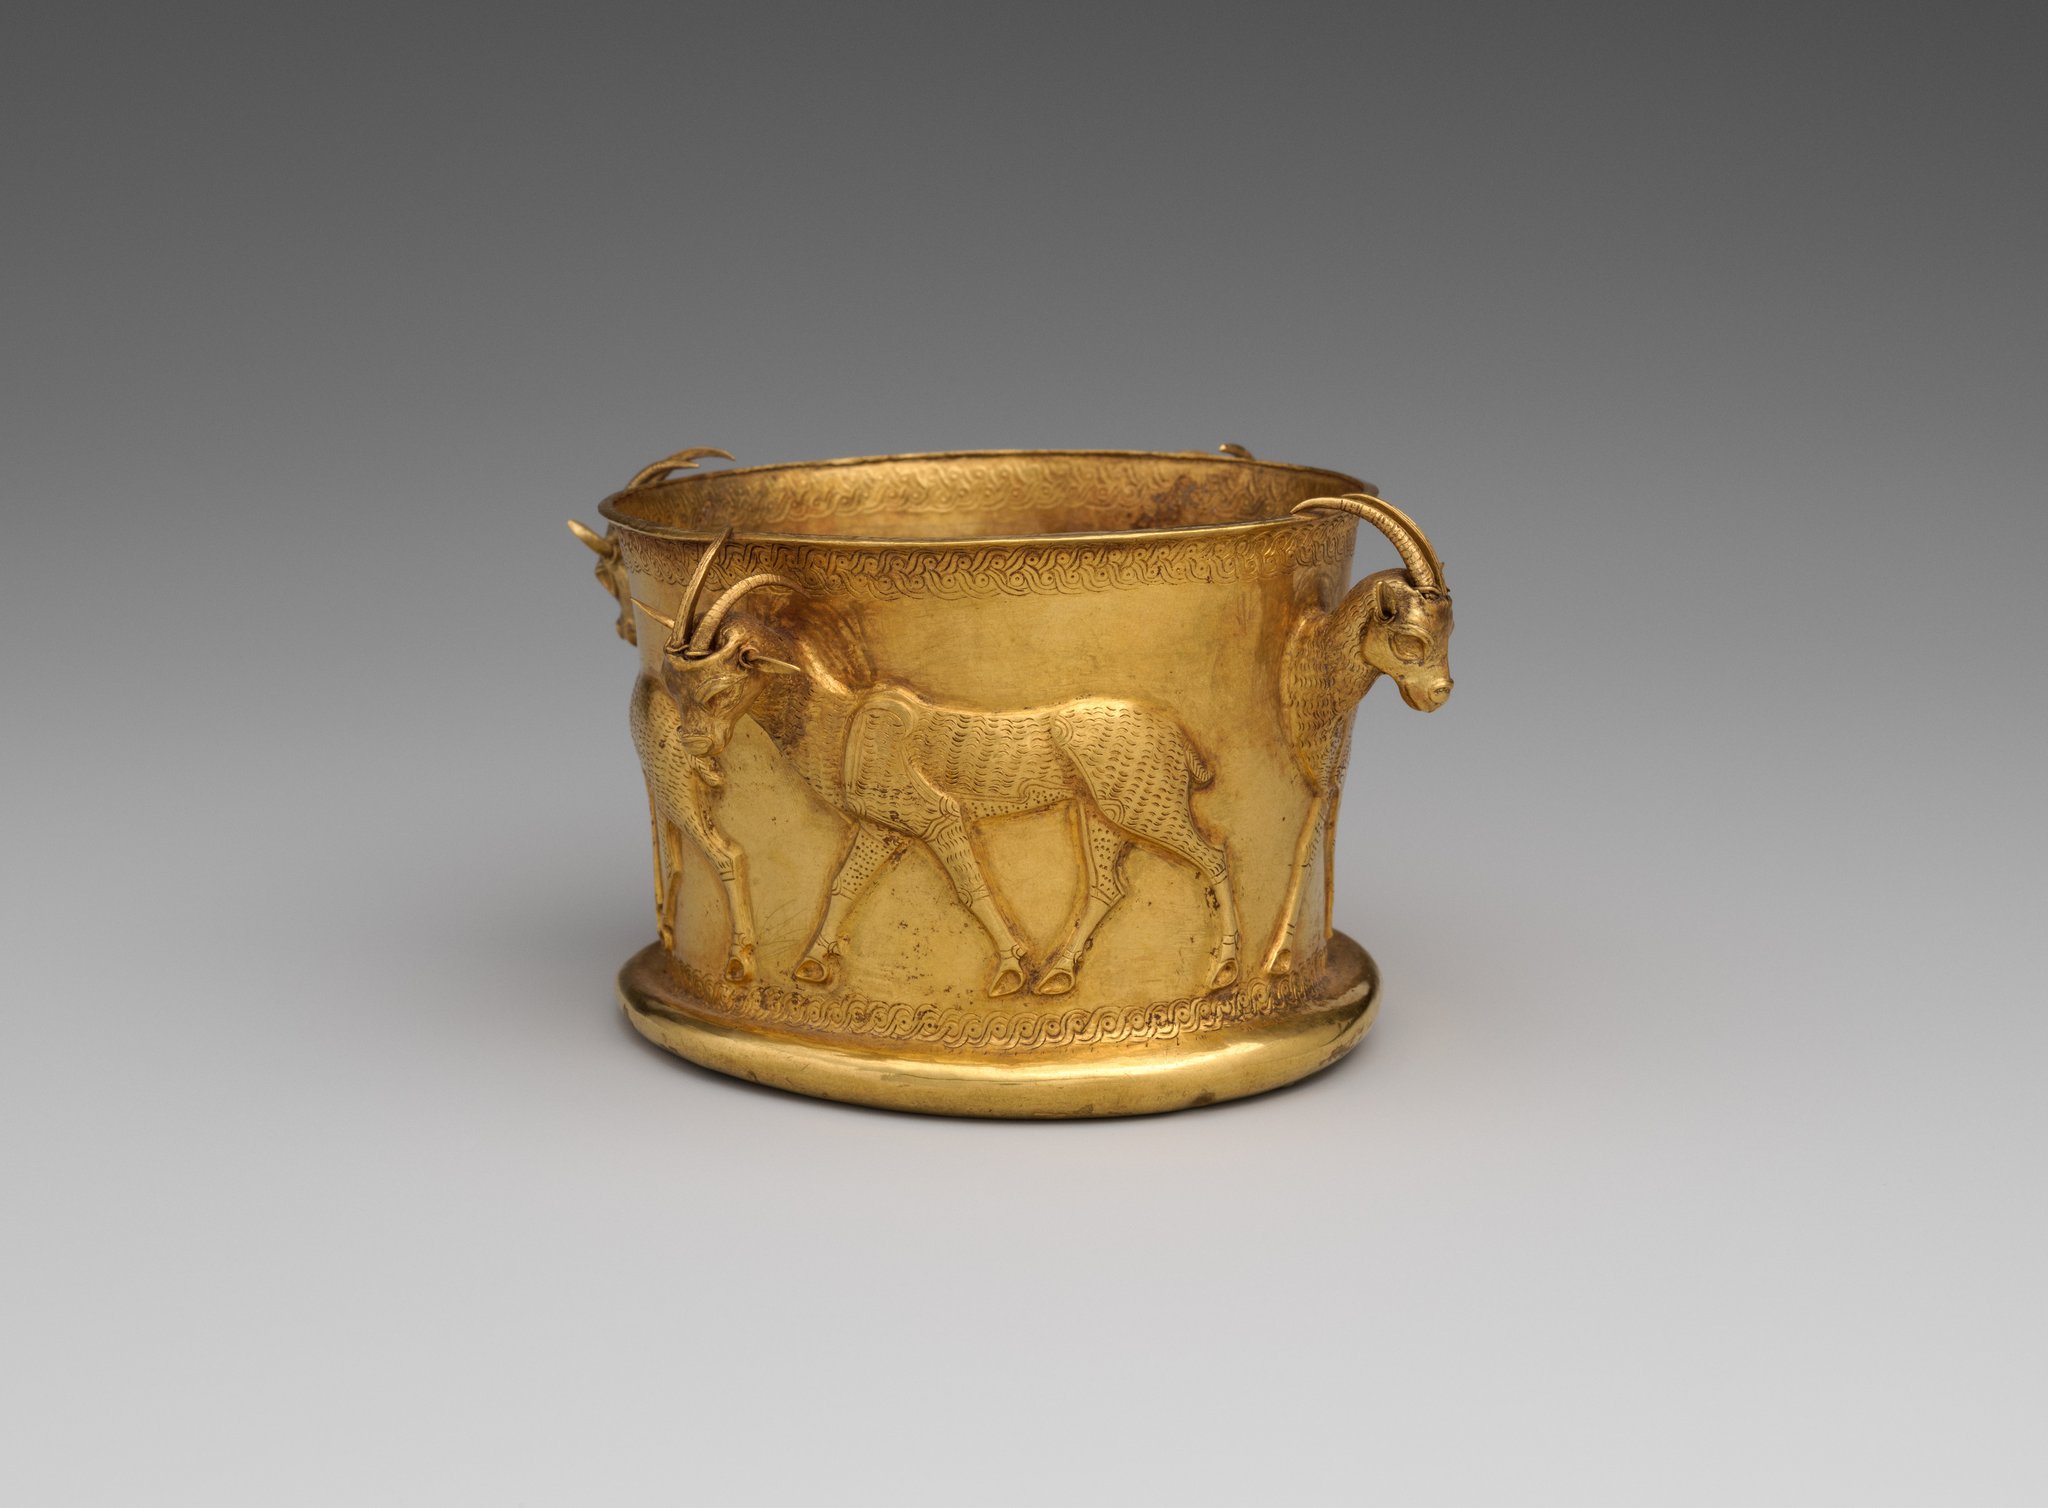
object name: cup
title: Cup with a frieze of gazelles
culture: iranian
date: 1000-668 BCE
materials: gold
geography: northwestern iran, caspian region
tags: animals